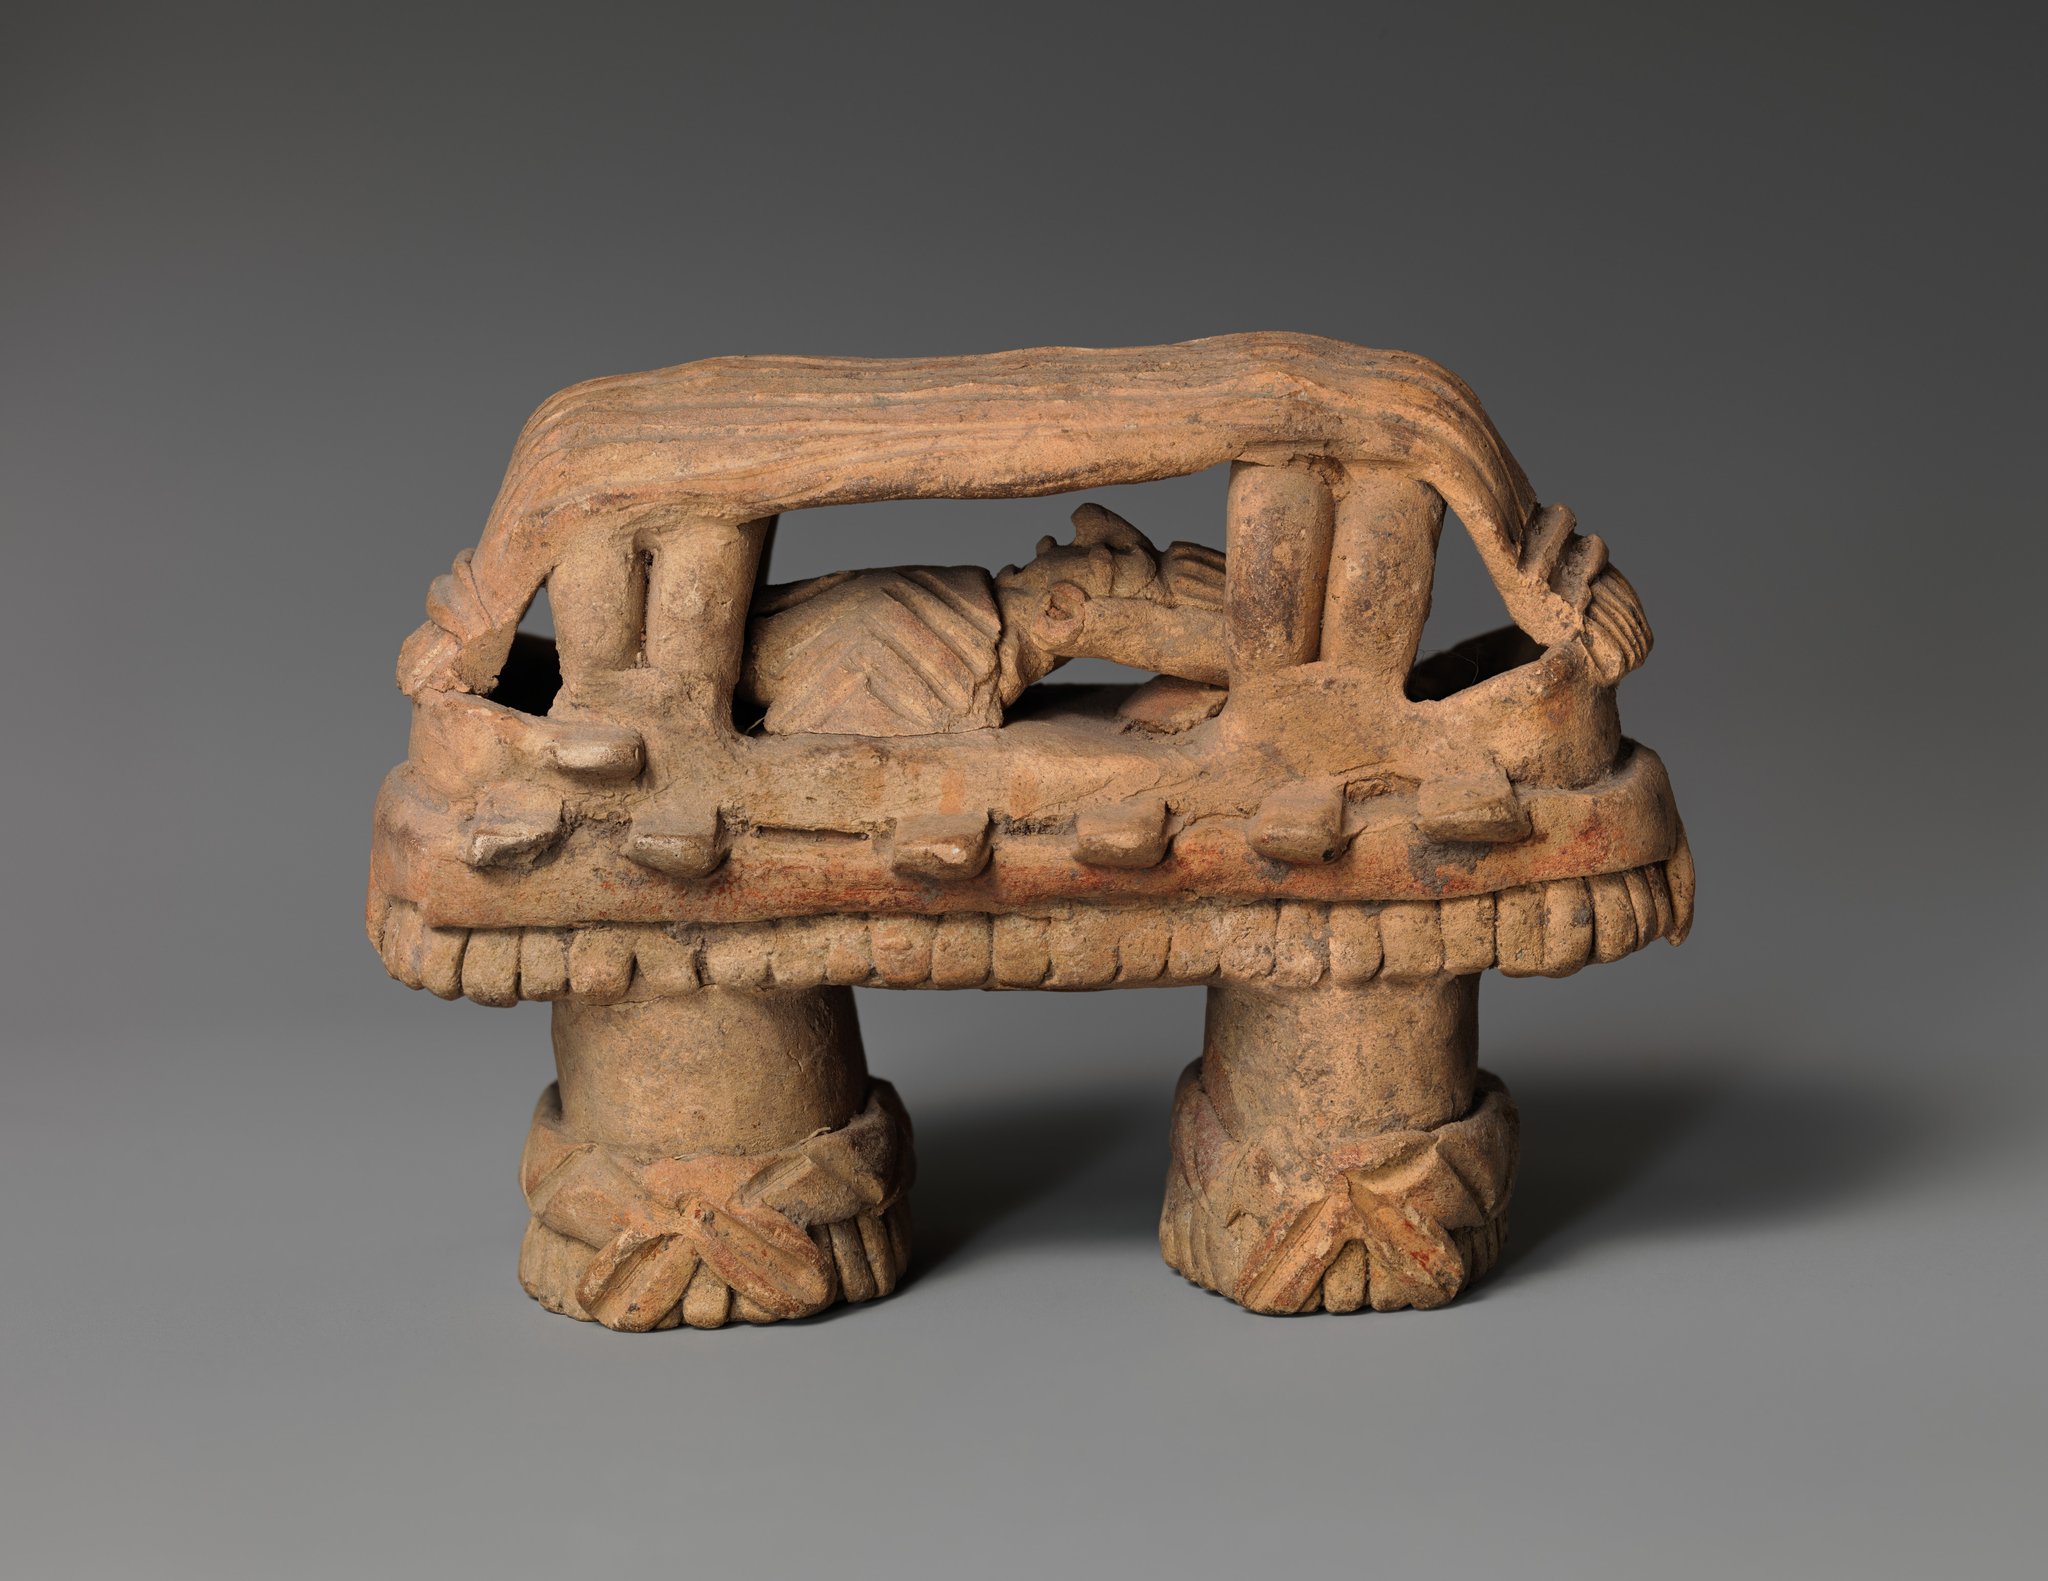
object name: figure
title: Bed Figure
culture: michoacan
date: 300 BCE-400 CE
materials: ceramic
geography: mexico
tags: human figures,beds